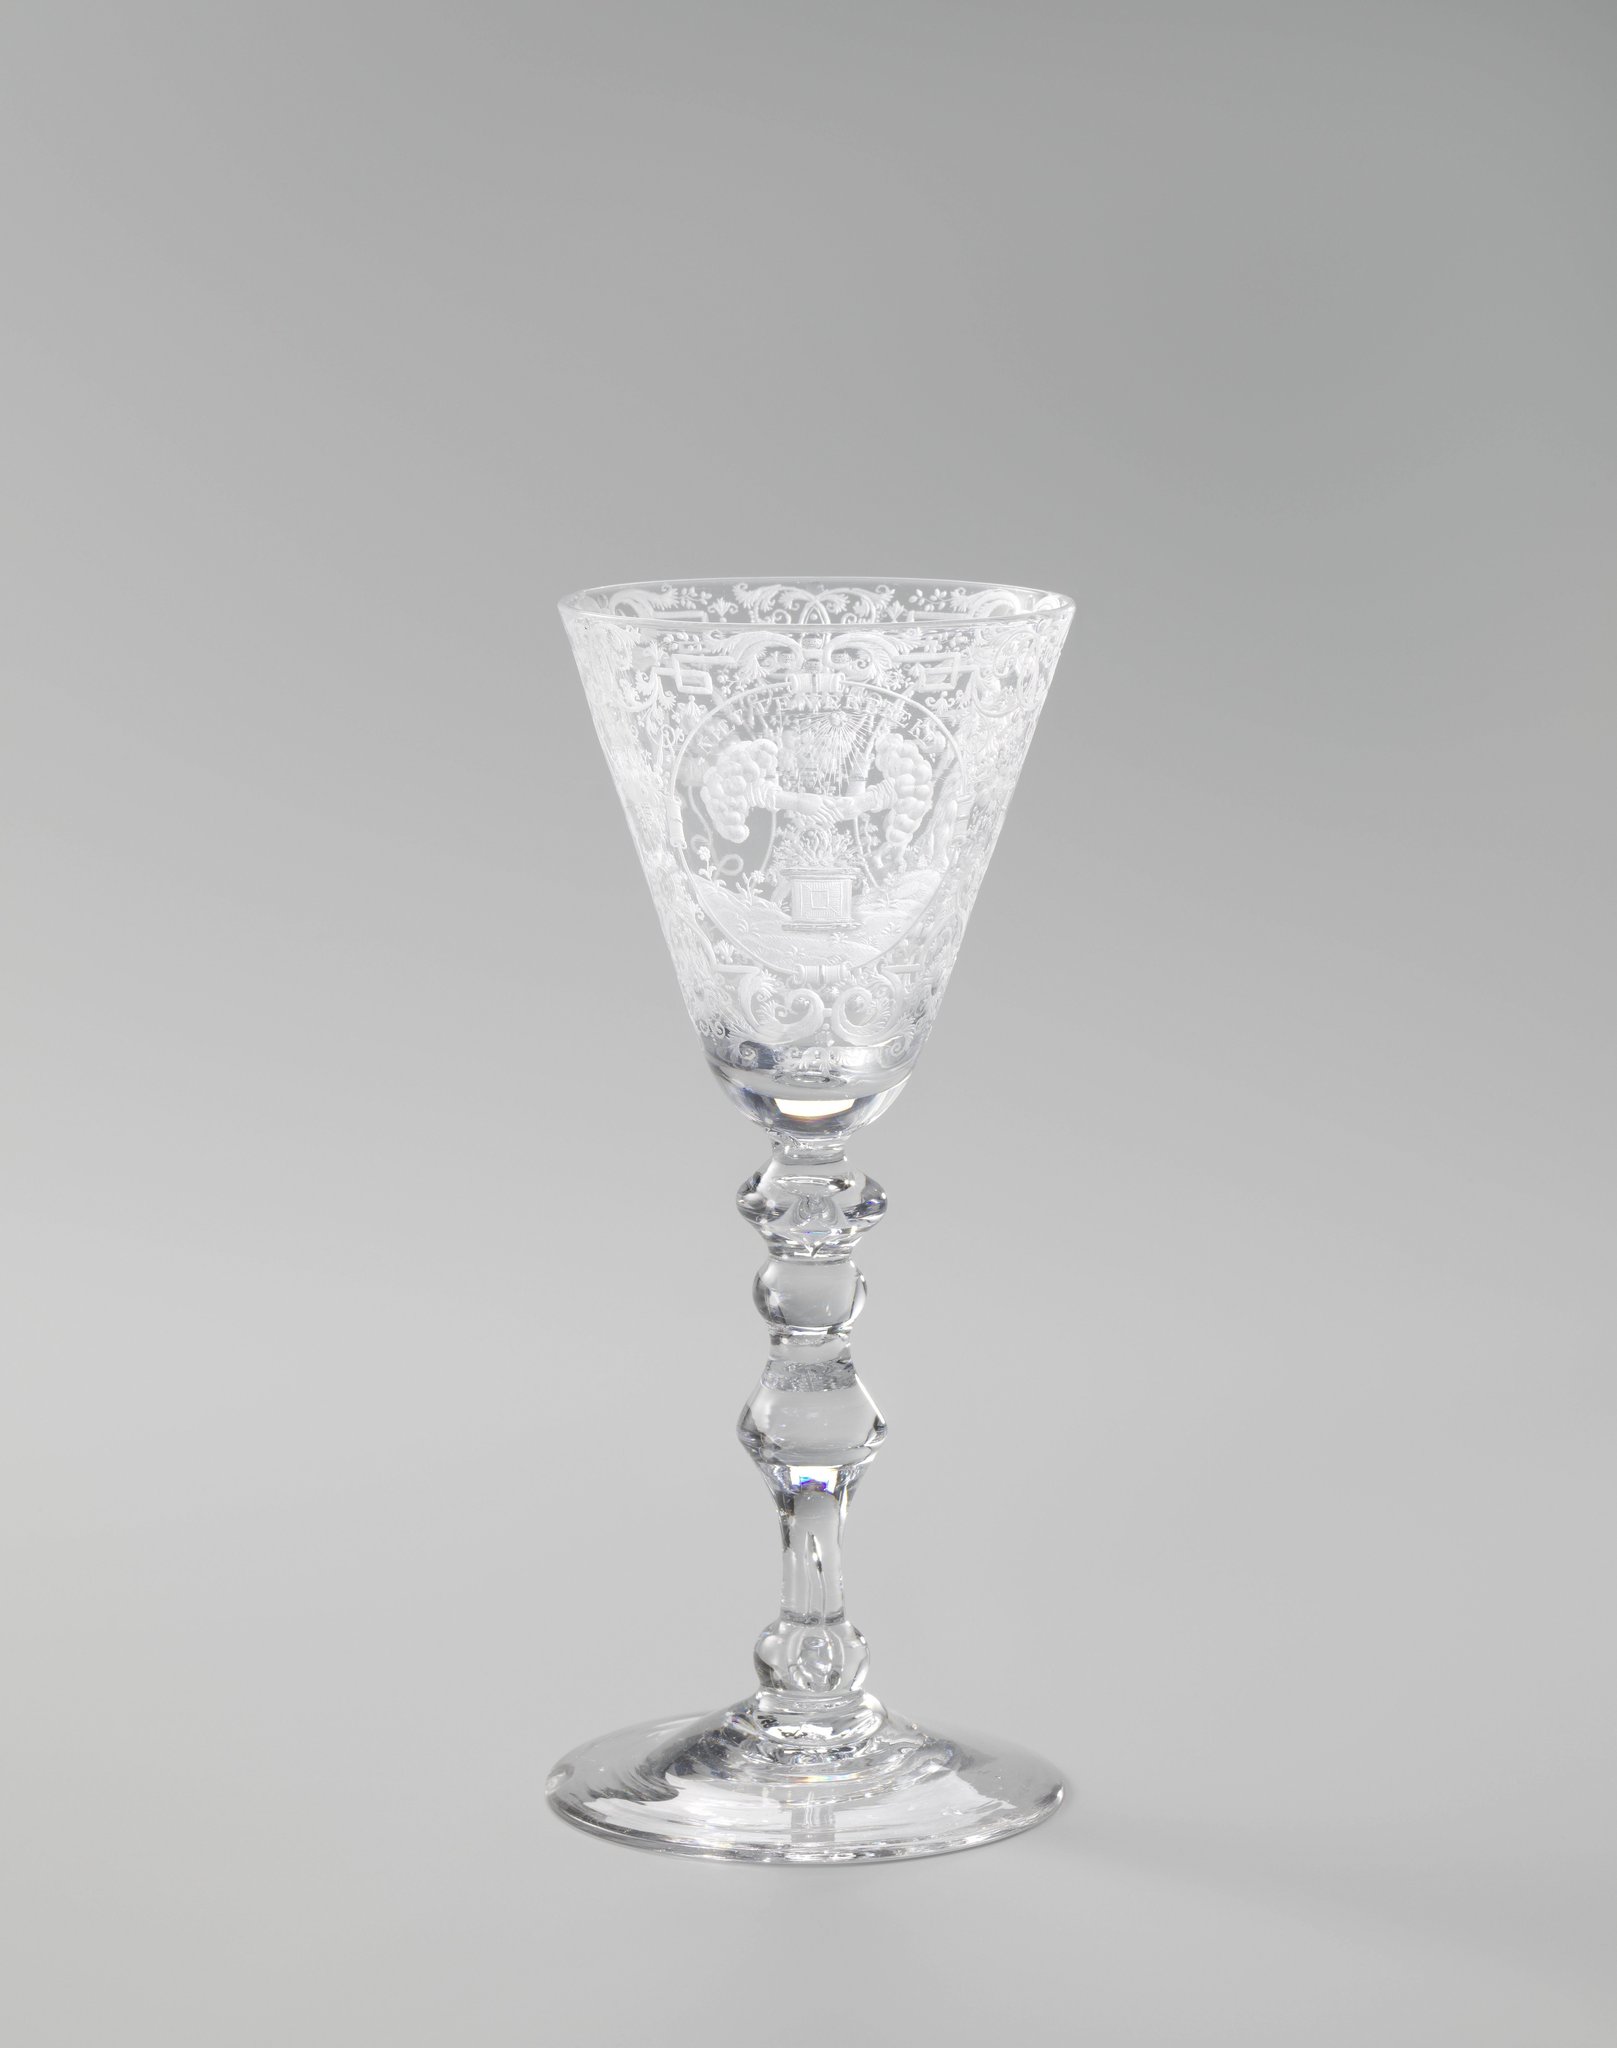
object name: goblet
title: Wine glass with scenes relating to marriage and fertility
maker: Anonymous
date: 1725-1750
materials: glass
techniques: glassblowing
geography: northern netherlands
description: translation of inscription: not to be broken